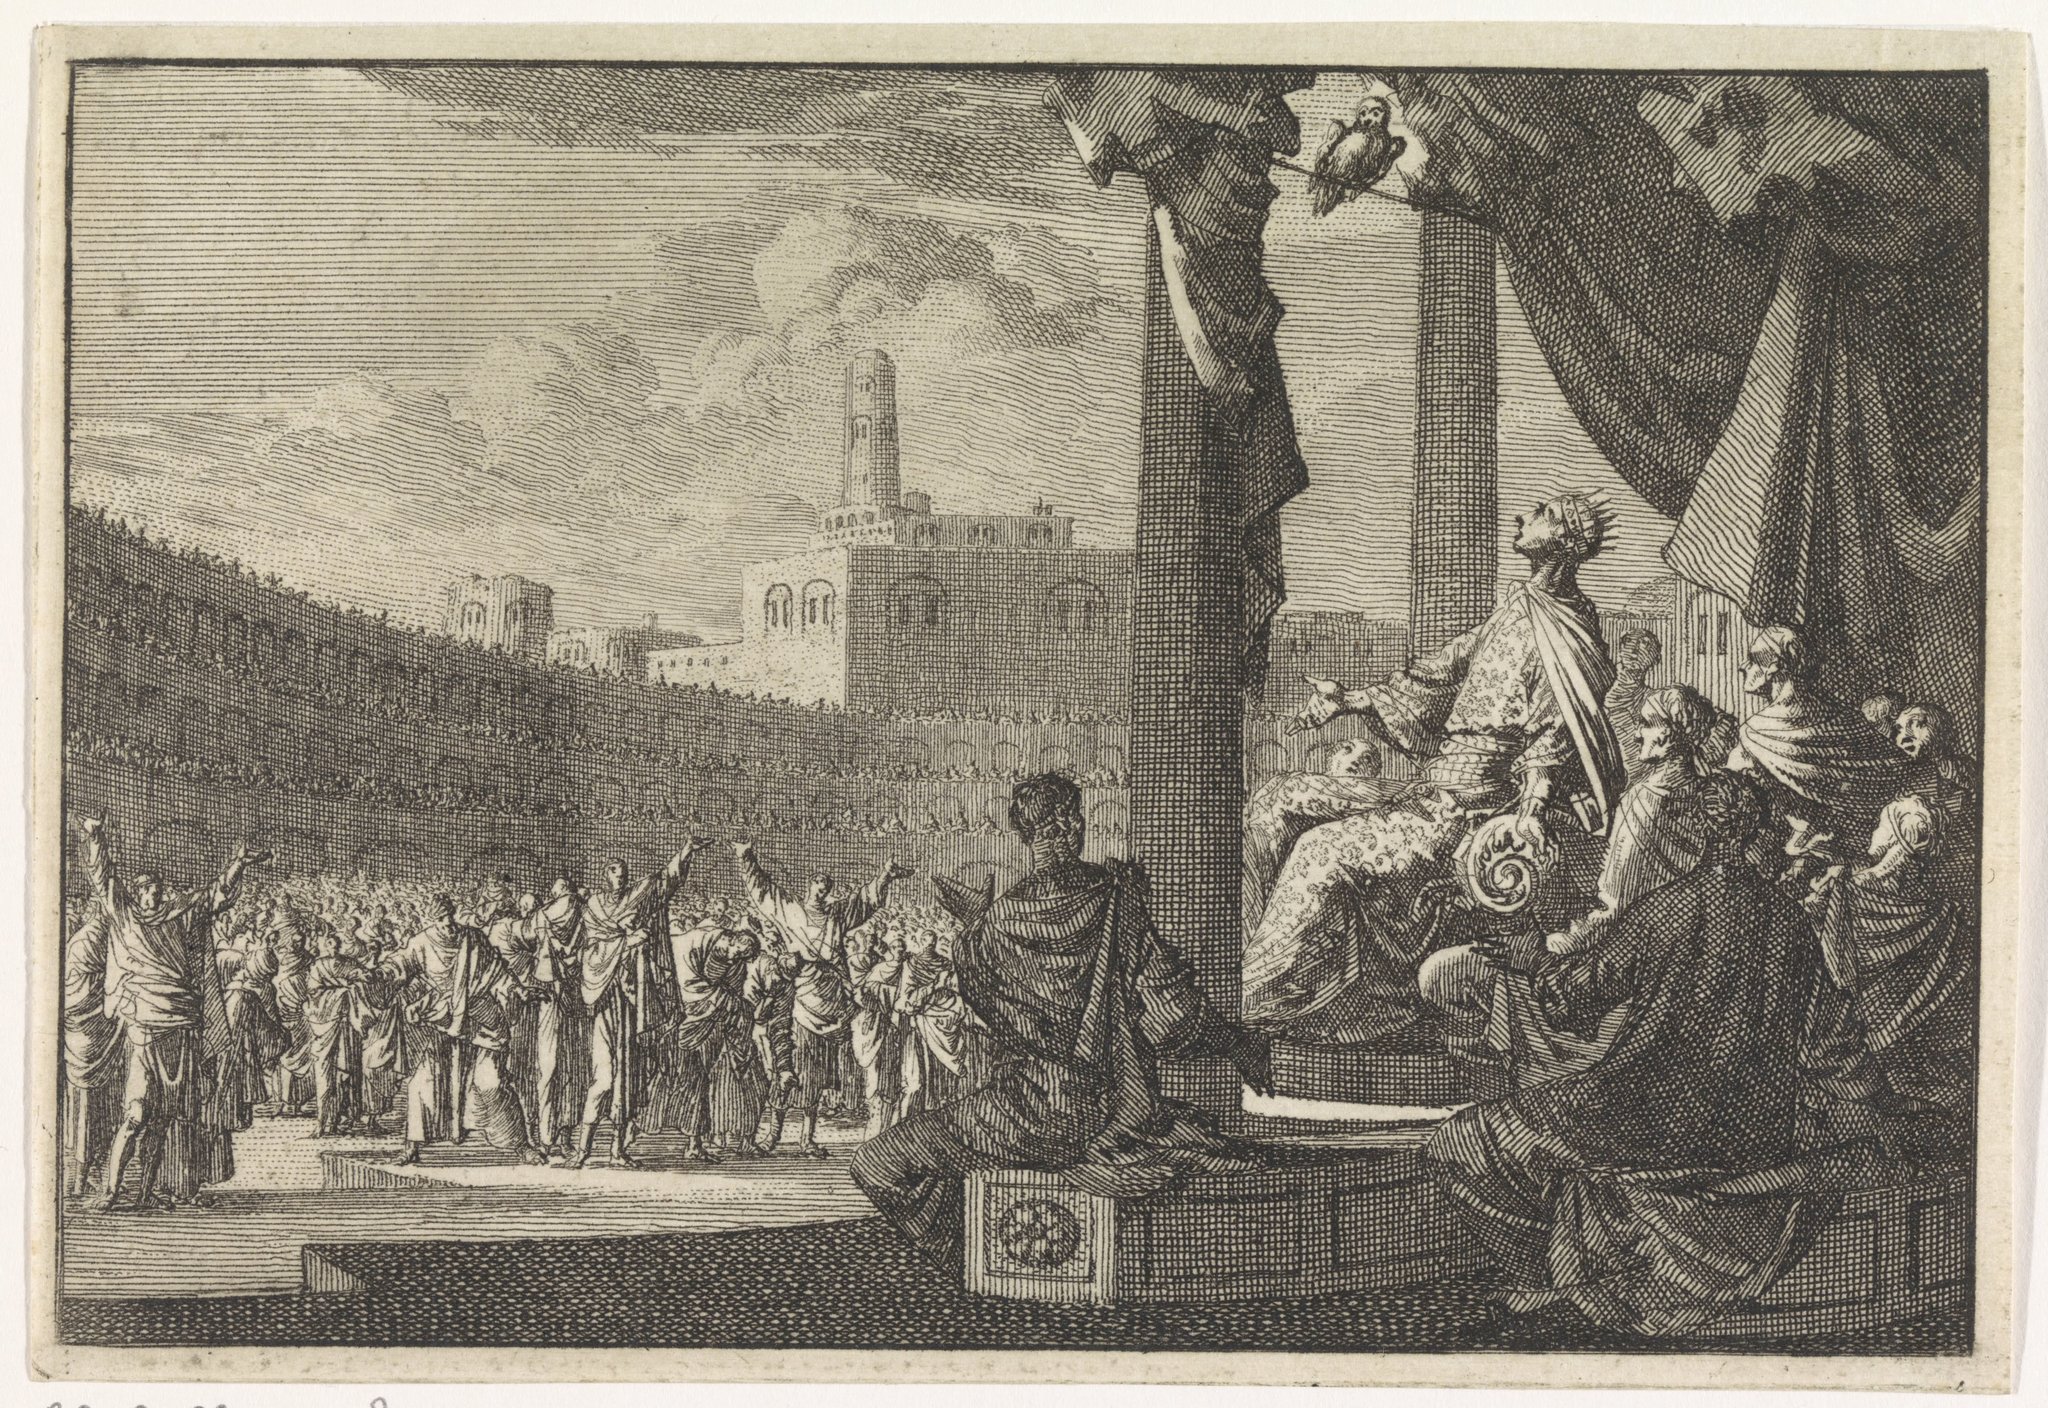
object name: print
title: Koning Agrippa ziet een uil boven zijn troon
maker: jan luyken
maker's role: draughtsman, print maker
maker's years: 1649-1712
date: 1704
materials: paper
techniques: etching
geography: amsterdam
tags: throne, owls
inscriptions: collector's mark: Lugt 2228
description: Prent ook gebruikt als boekillustratie in: Josephus, Flavius. Alle de Werken, 2 delen. Amsterdam: Pieter Mortier, 1704, dl. 1, p. 468.